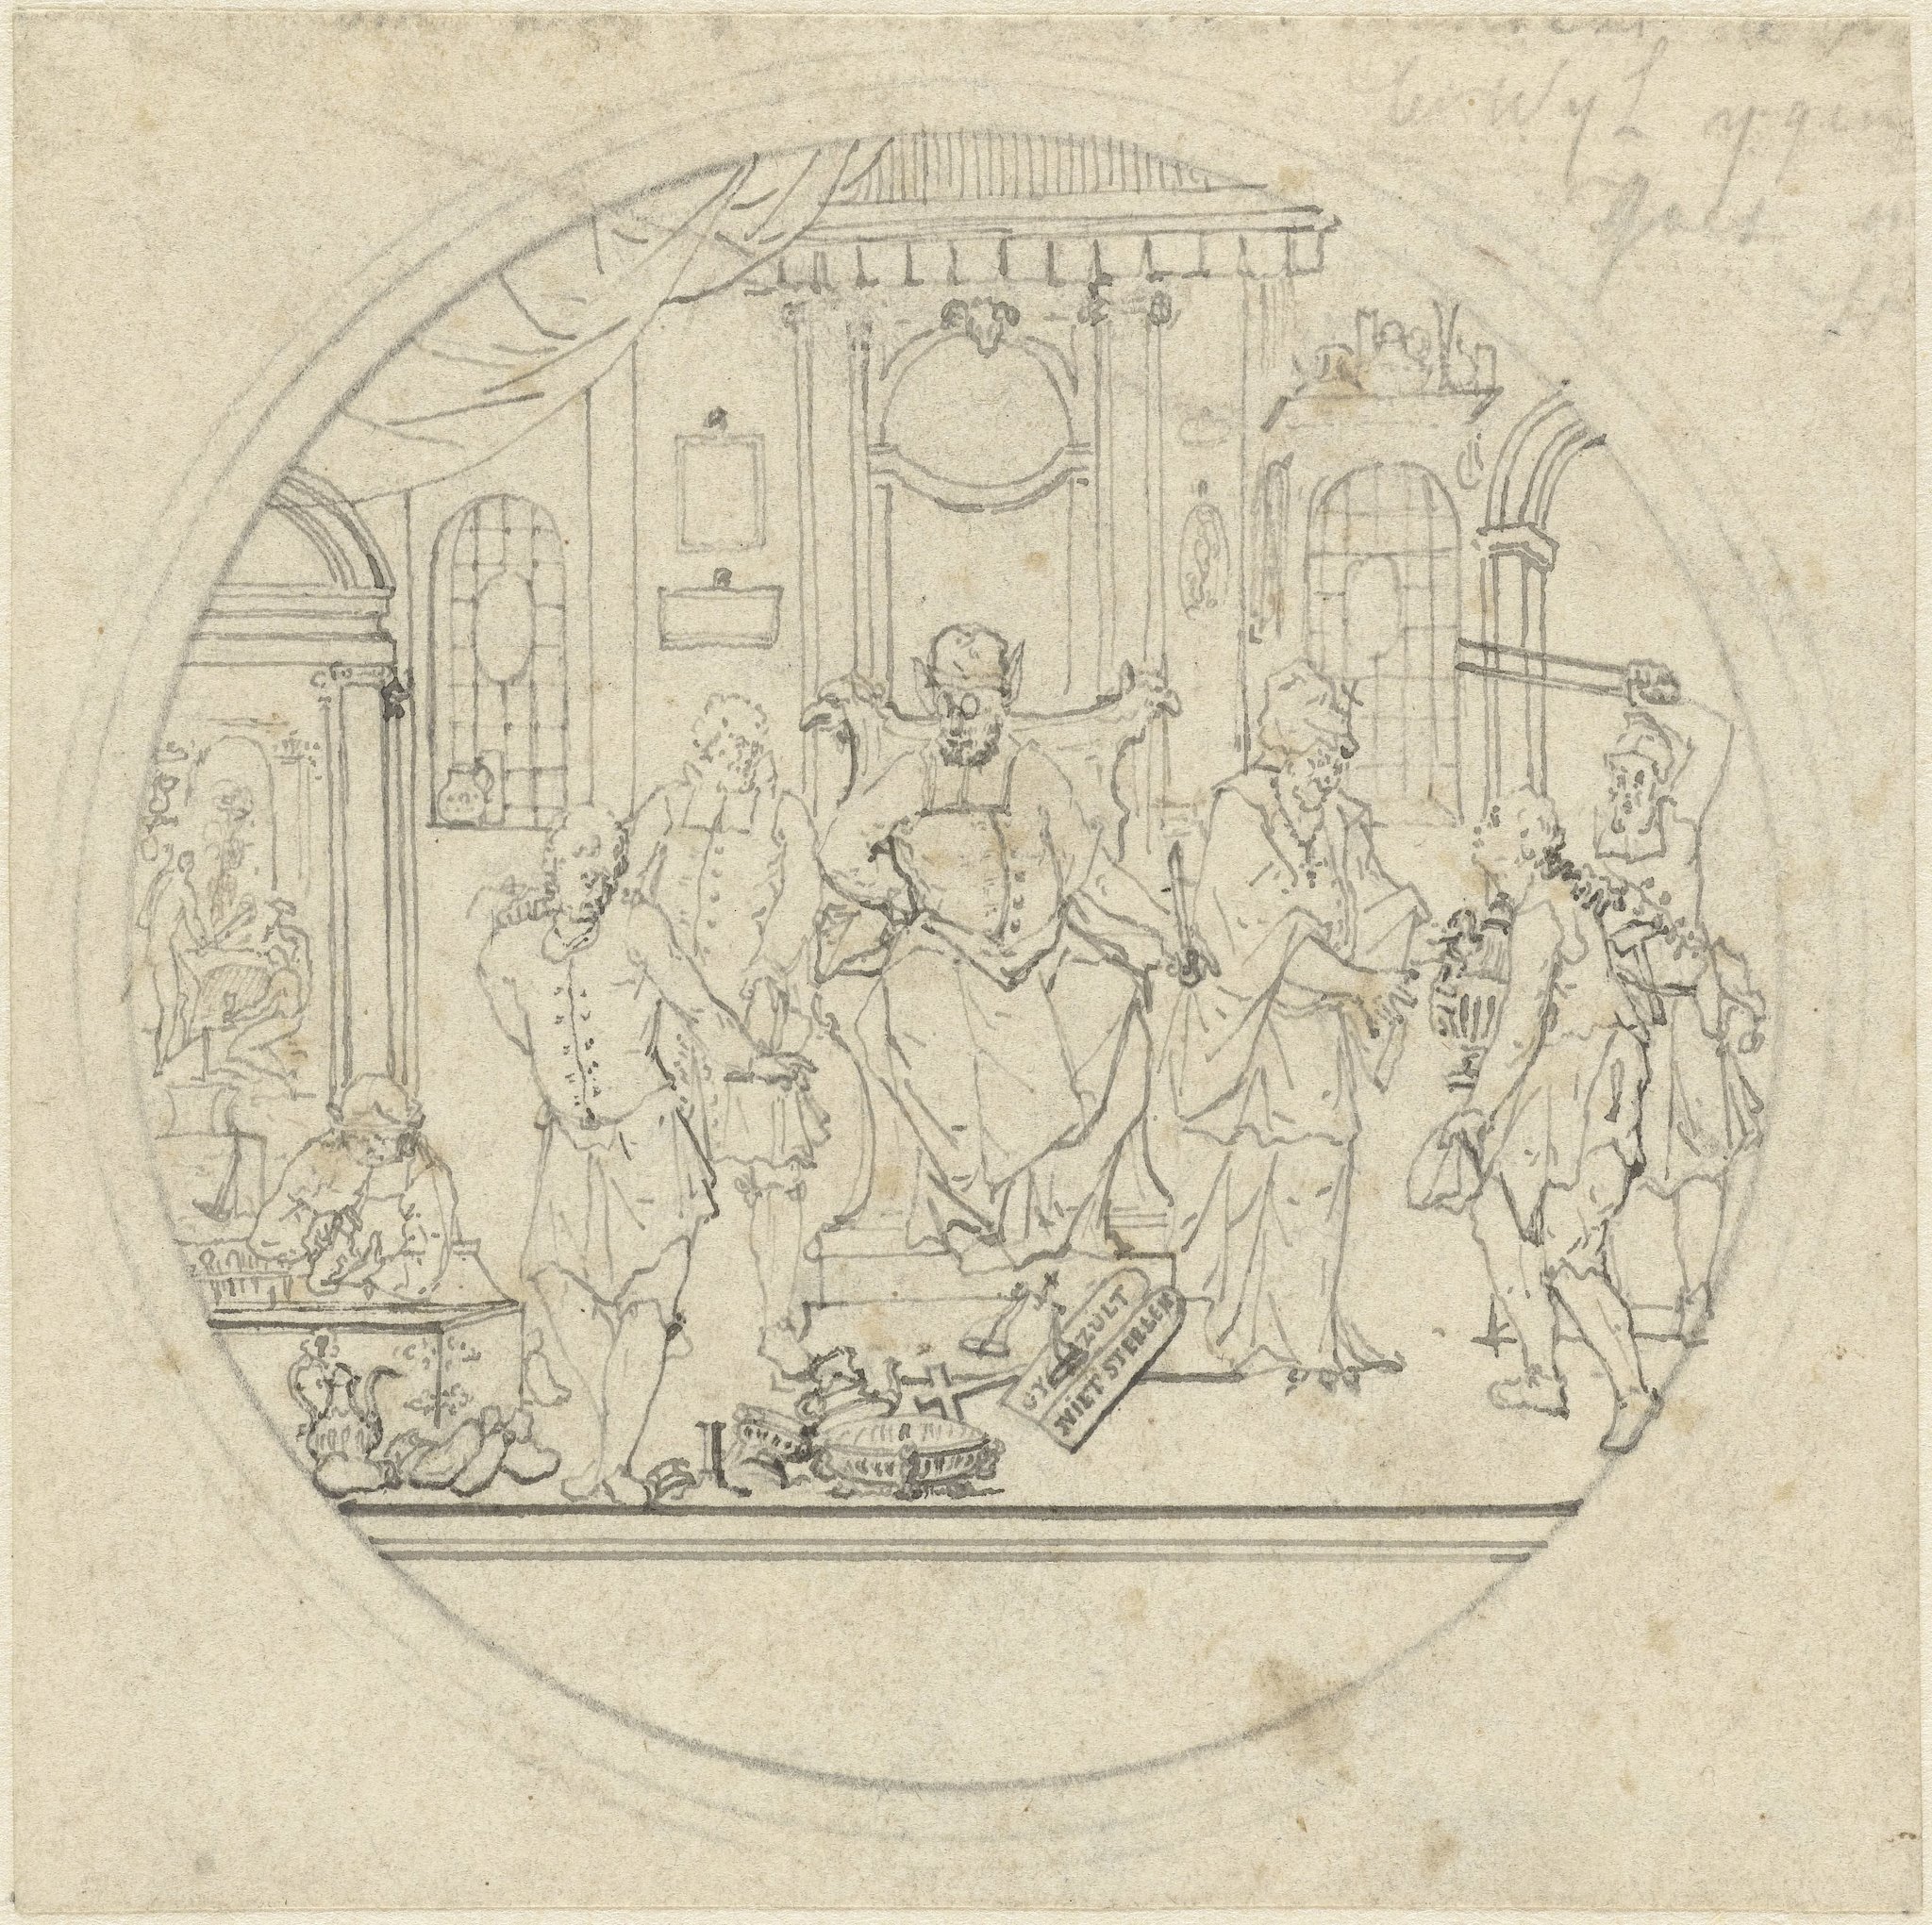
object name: drawing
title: Ronde voorstelling met allegorie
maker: bernard picart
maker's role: draughtsman, print maker, publisher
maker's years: 1673-1733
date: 1683-1733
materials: ink, paper, pencil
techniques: pen